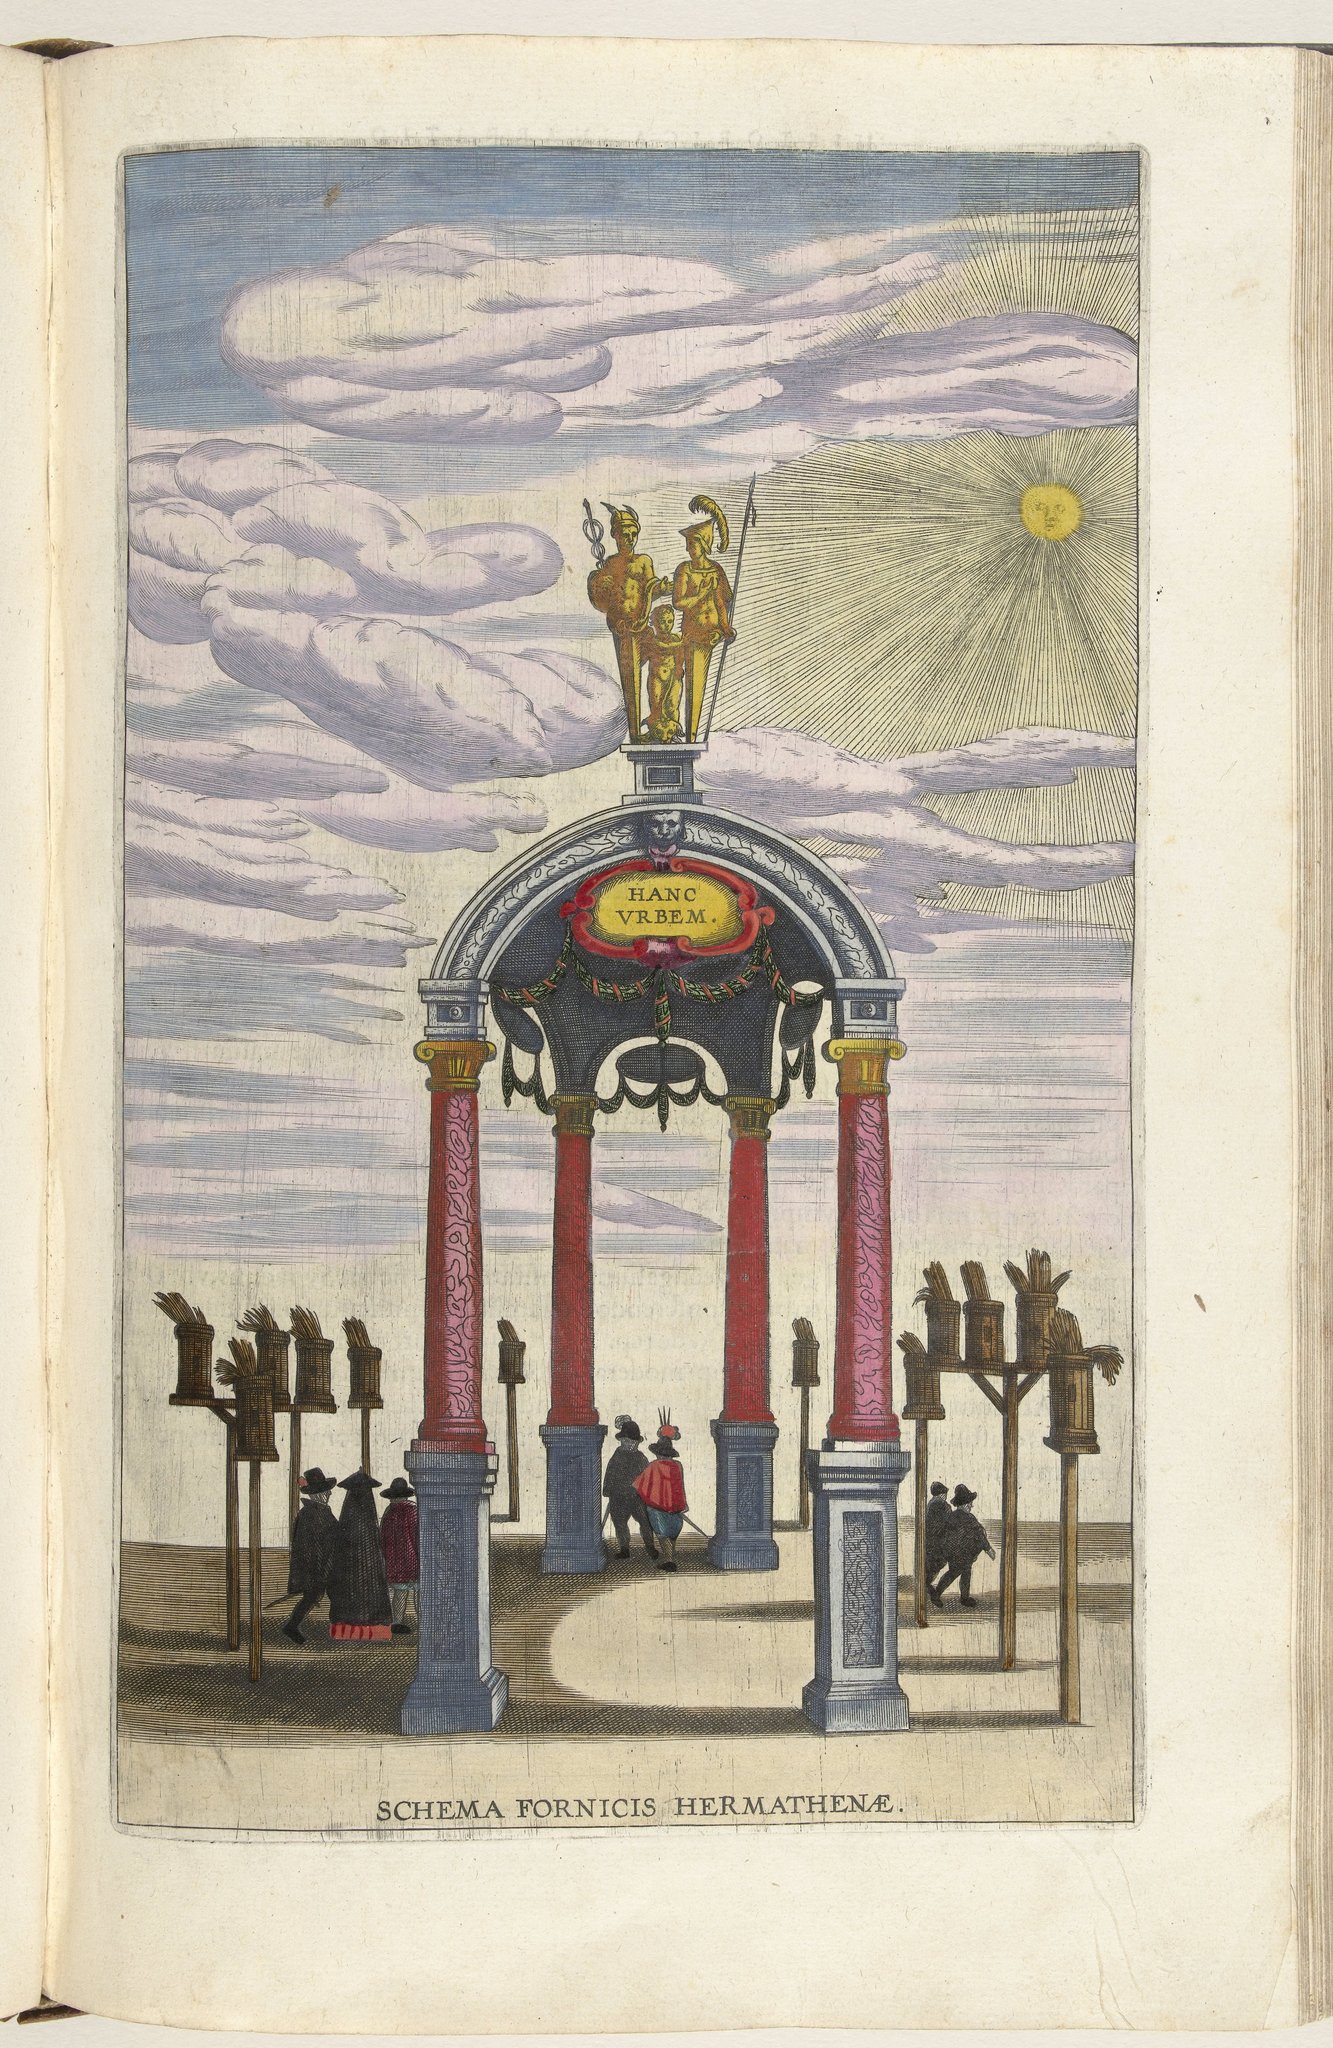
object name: print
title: Schema fornicis hermathenae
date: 1599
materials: paper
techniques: engraving, hand coloring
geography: southern netherlands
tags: infante van spanje isabella clara eugenia, brussels, albrecht aartshertog van oostenrijk, triumphal arch, triumphal entry and public reception, pageant, 'entrée solennelle', 'joyeuse entrée', antwerp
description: Kleine triomfpoort met hermen, december 1599. Triomfpoort bovenop versierd met hermen van Mercurius en Minerva. In de openlucht met een stralende zon. Tijdens de intocht te Antwerpen. Onderdeel van: Historica narratio profectionis et inaugurationis serenissimorum Belgii principum Alberti et Isabellae Austriae archiducum, de beschrijving van de intochten van het paar te Brussel, Antwerpen, Gent en Valenciennes, 1599.